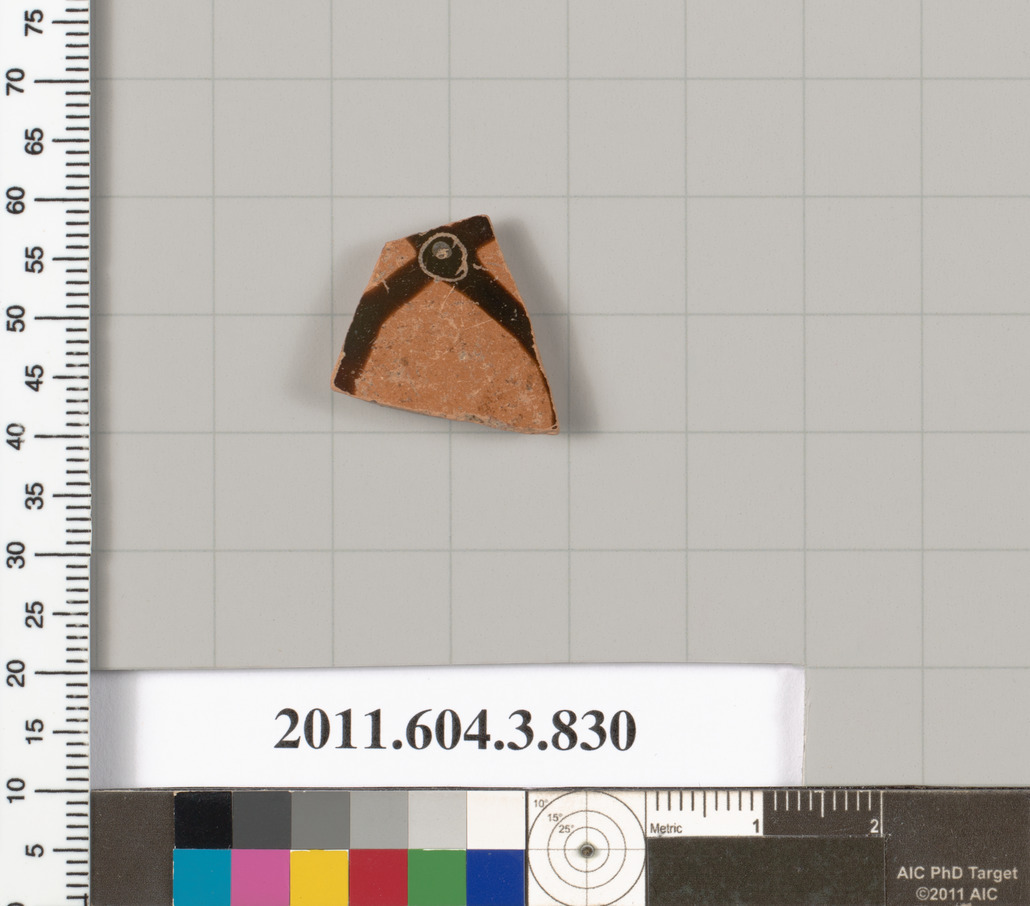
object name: lekythos fragment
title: Terracotta fragment of a lekythos (oil flask)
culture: greek, attic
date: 534-501 BCE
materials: terracotta